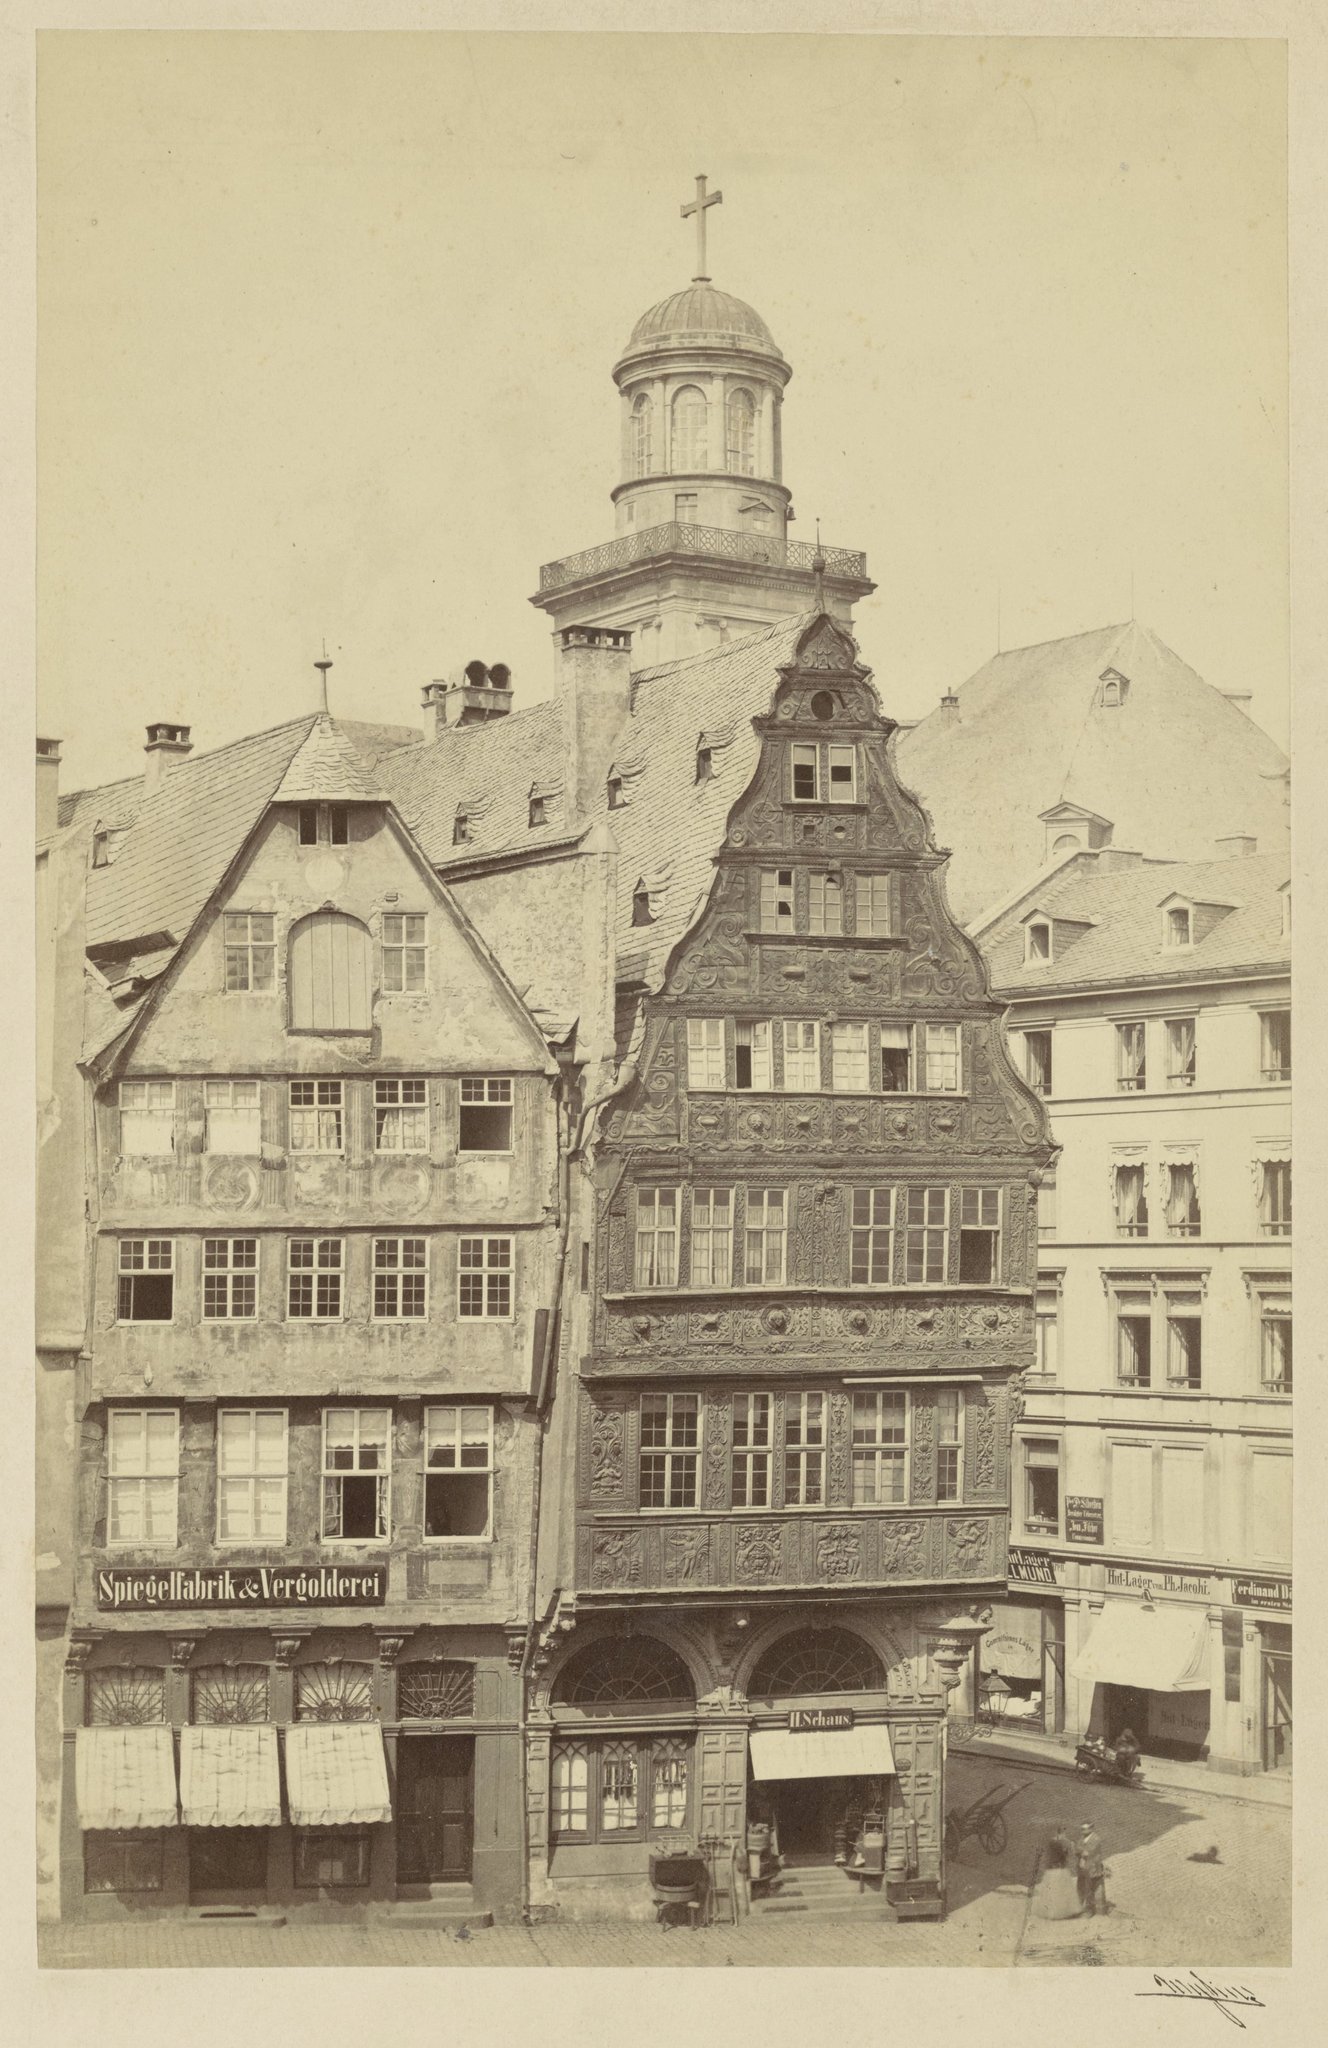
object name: photograph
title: Woningen in de wijk Römer in Frankfurt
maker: carl friedrich mylius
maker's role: draughtsman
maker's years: 1827-1916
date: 1870-1890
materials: cardboard, paper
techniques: albumen print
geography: frankfurt am main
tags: urban housing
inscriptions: inscription: ‘Frankfurt a.M./ altes Haus auf dem Römerberg’